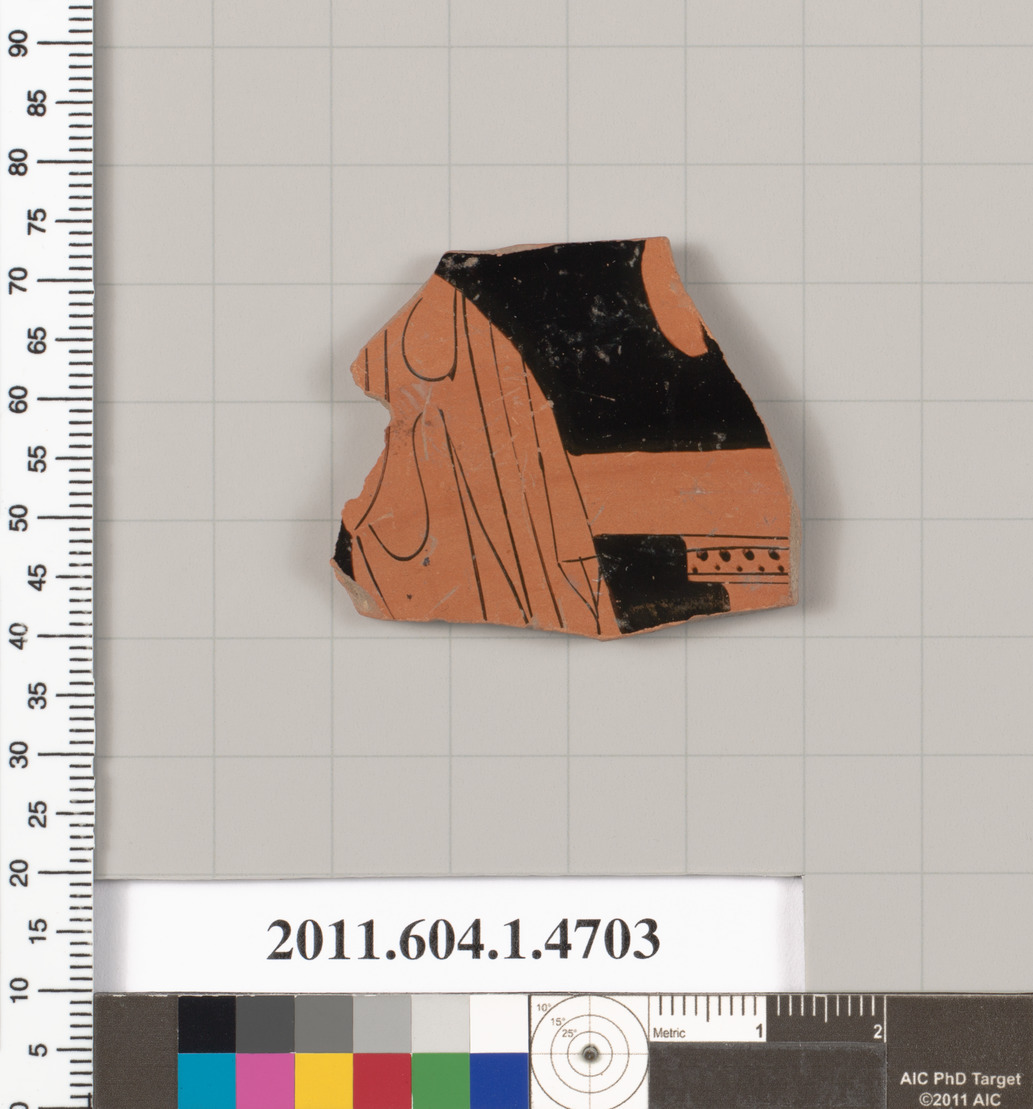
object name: kylix fragment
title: Terracotta fragment of a kylix (drinking cup)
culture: greek, attic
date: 475-451 BCE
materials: terracotta